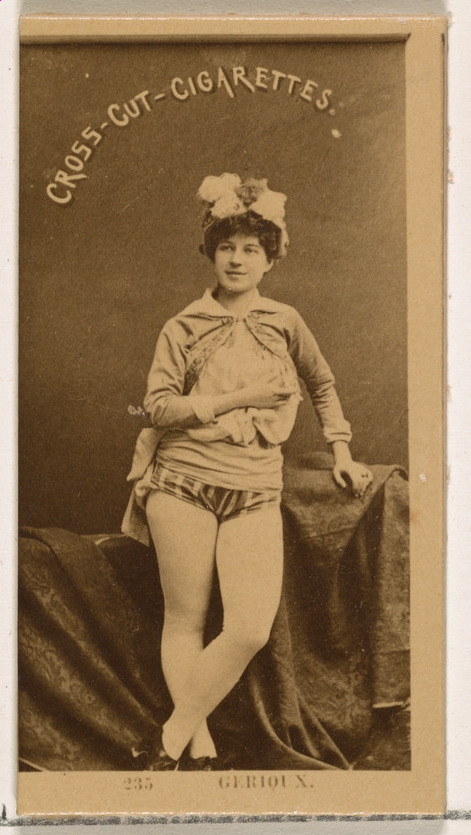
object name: print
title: Card Number 235, Gerioux, from the Actors and Actresses series (N145-2) issued by Duke Sons & Co. to promote Cross Cut Cigarettes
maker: w. duke, sons & co.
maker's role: publisher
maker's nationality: american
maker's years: 1870-1920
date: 1880-1889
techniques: albumen silver print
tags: portraits,women,actresses